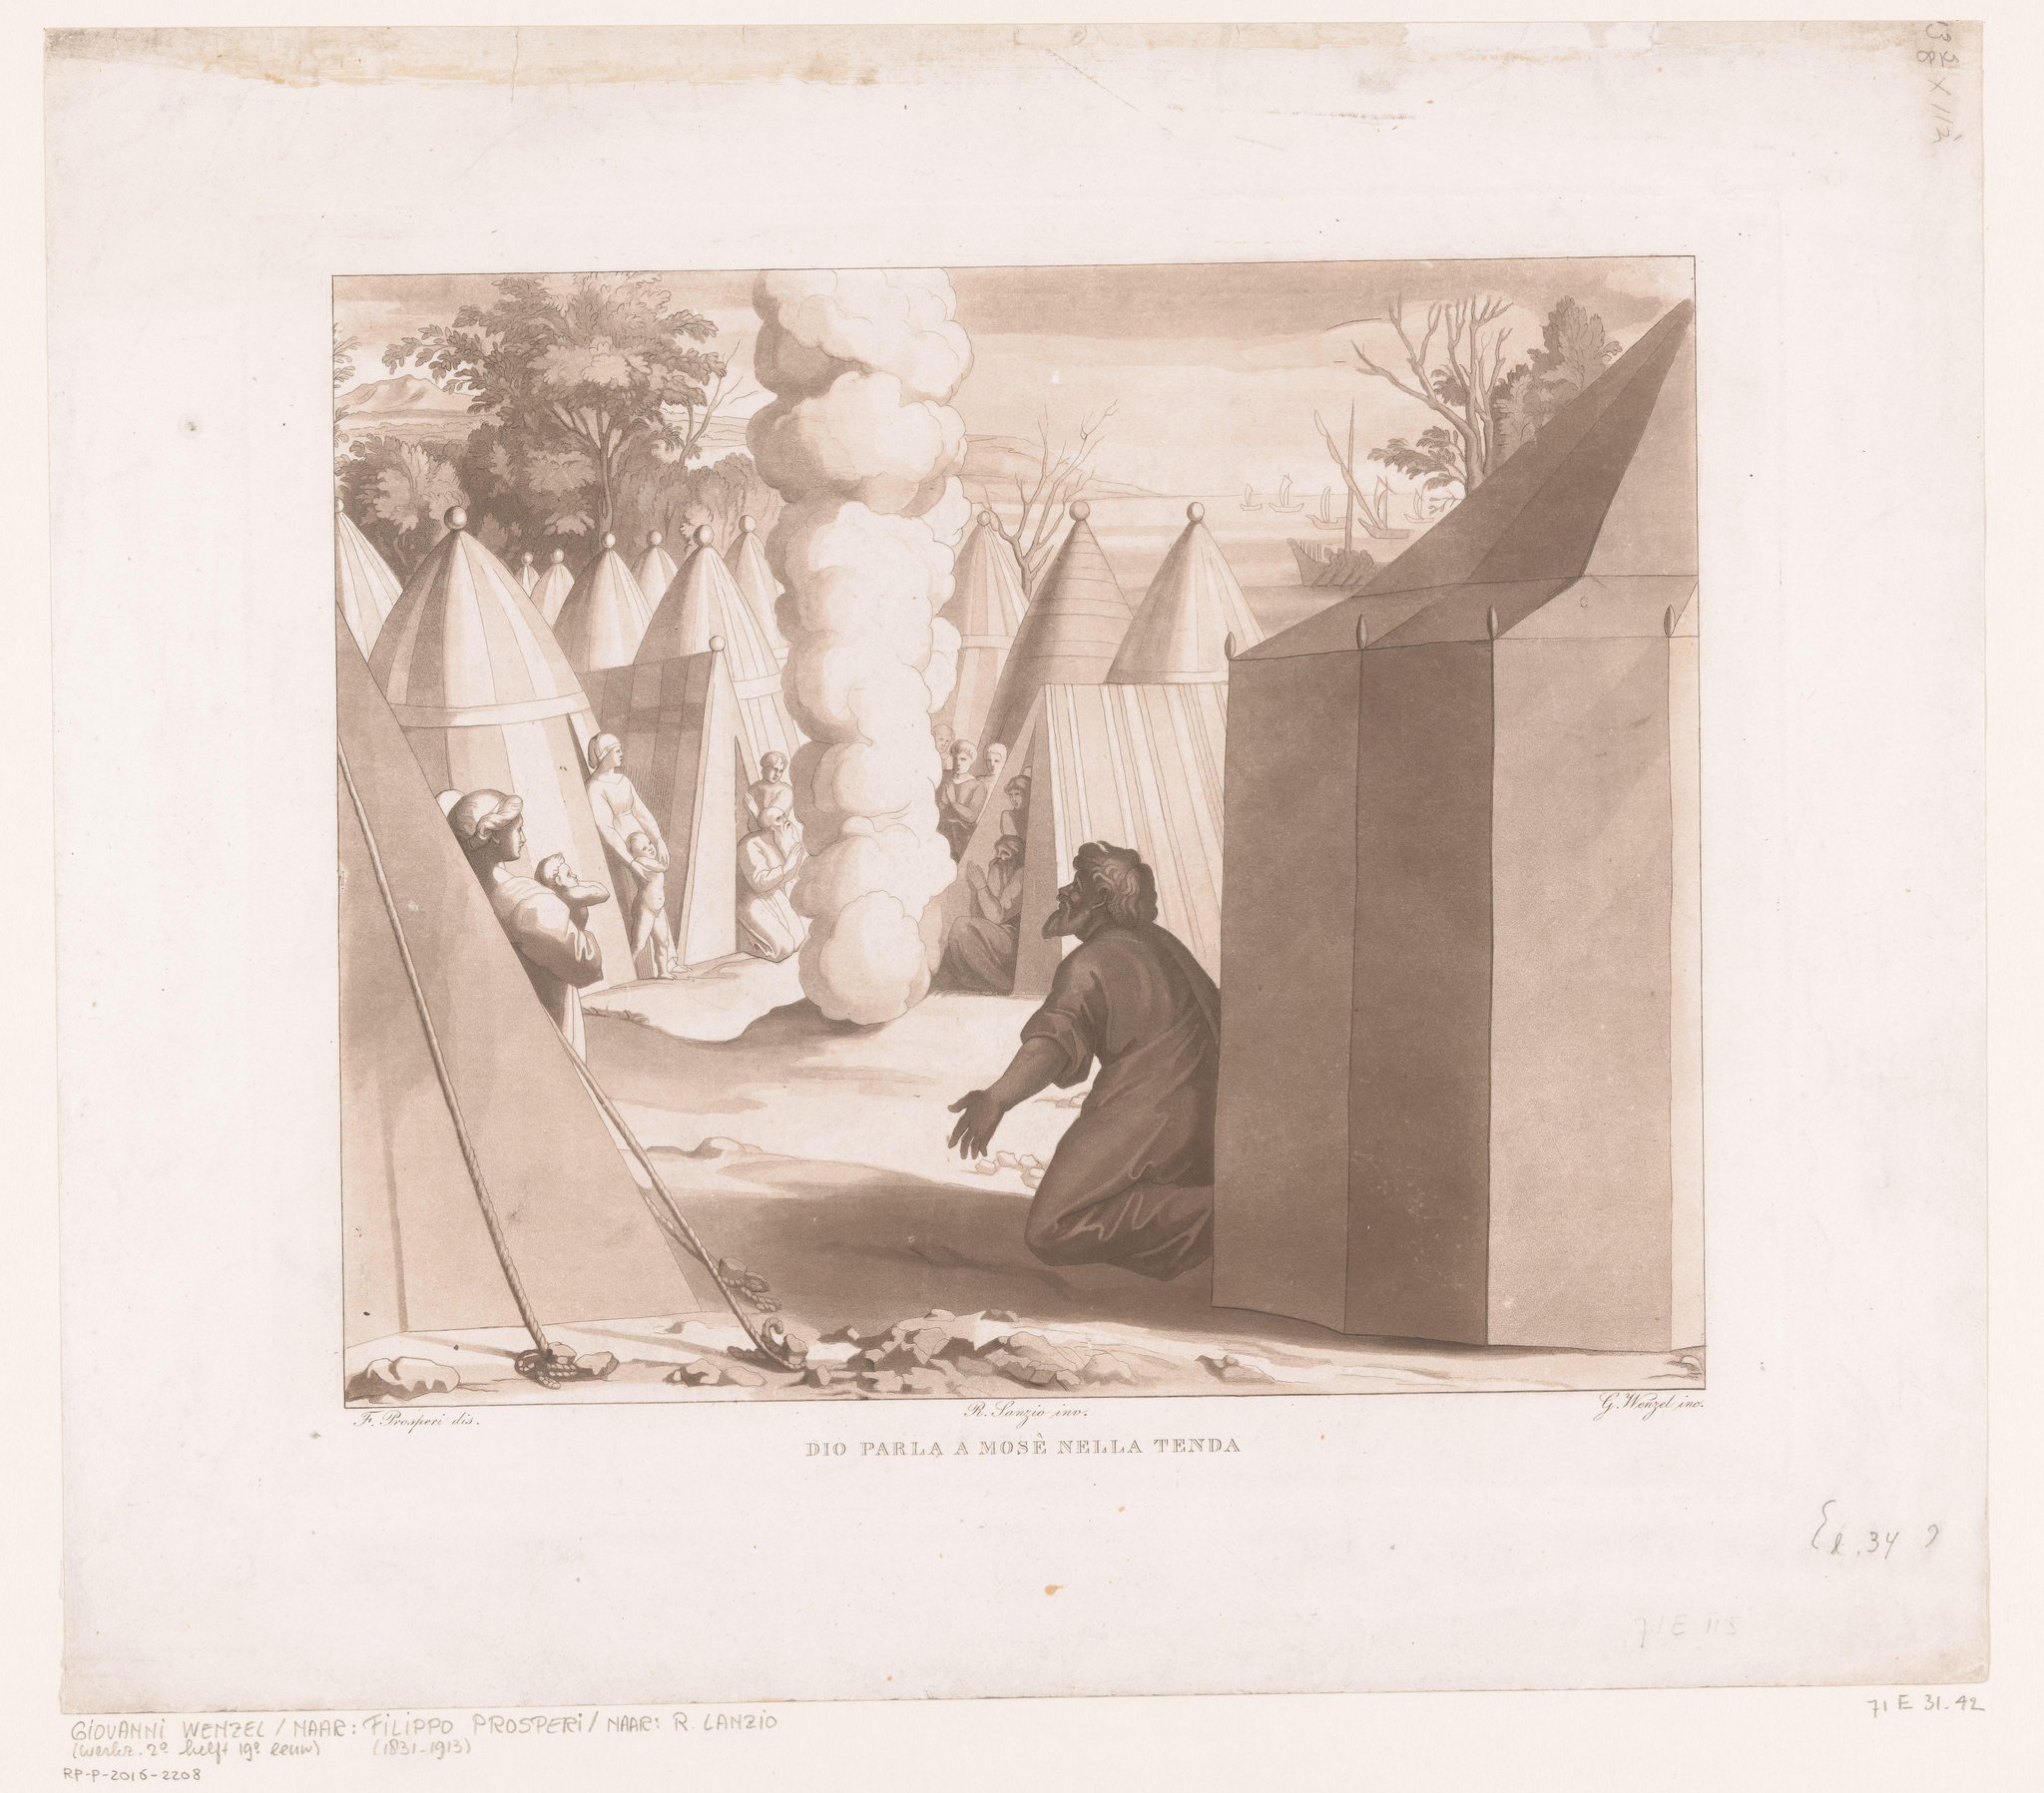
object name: print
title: God verschijnt aan Mozes in een rookkolom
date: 1844-1850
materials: paper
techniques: aquatint, etching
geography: rome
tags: when moses abides in the tabernacle, the pillar of cloud comes down and stays at the door; the people gather at the entrance of their tents and bow down in reverence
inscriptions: collector's mark: Lugt 2228